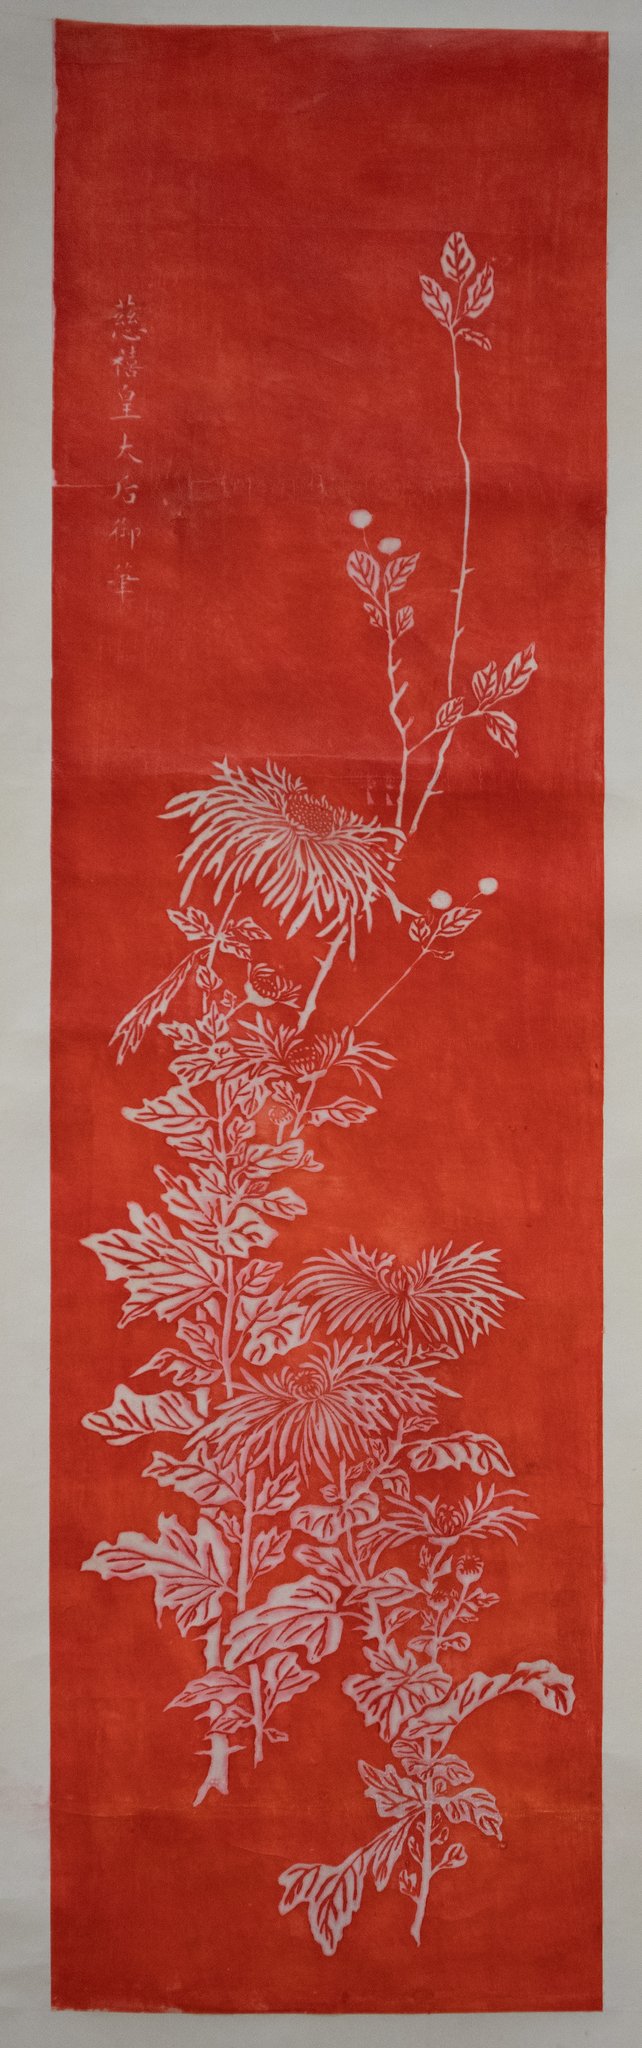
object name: print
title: Chrysanthemums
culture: chinese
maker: kuang xü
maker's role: artist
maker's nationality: chinese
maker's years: 1874-1909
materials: ink, paper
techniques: polychrome, woodblock print